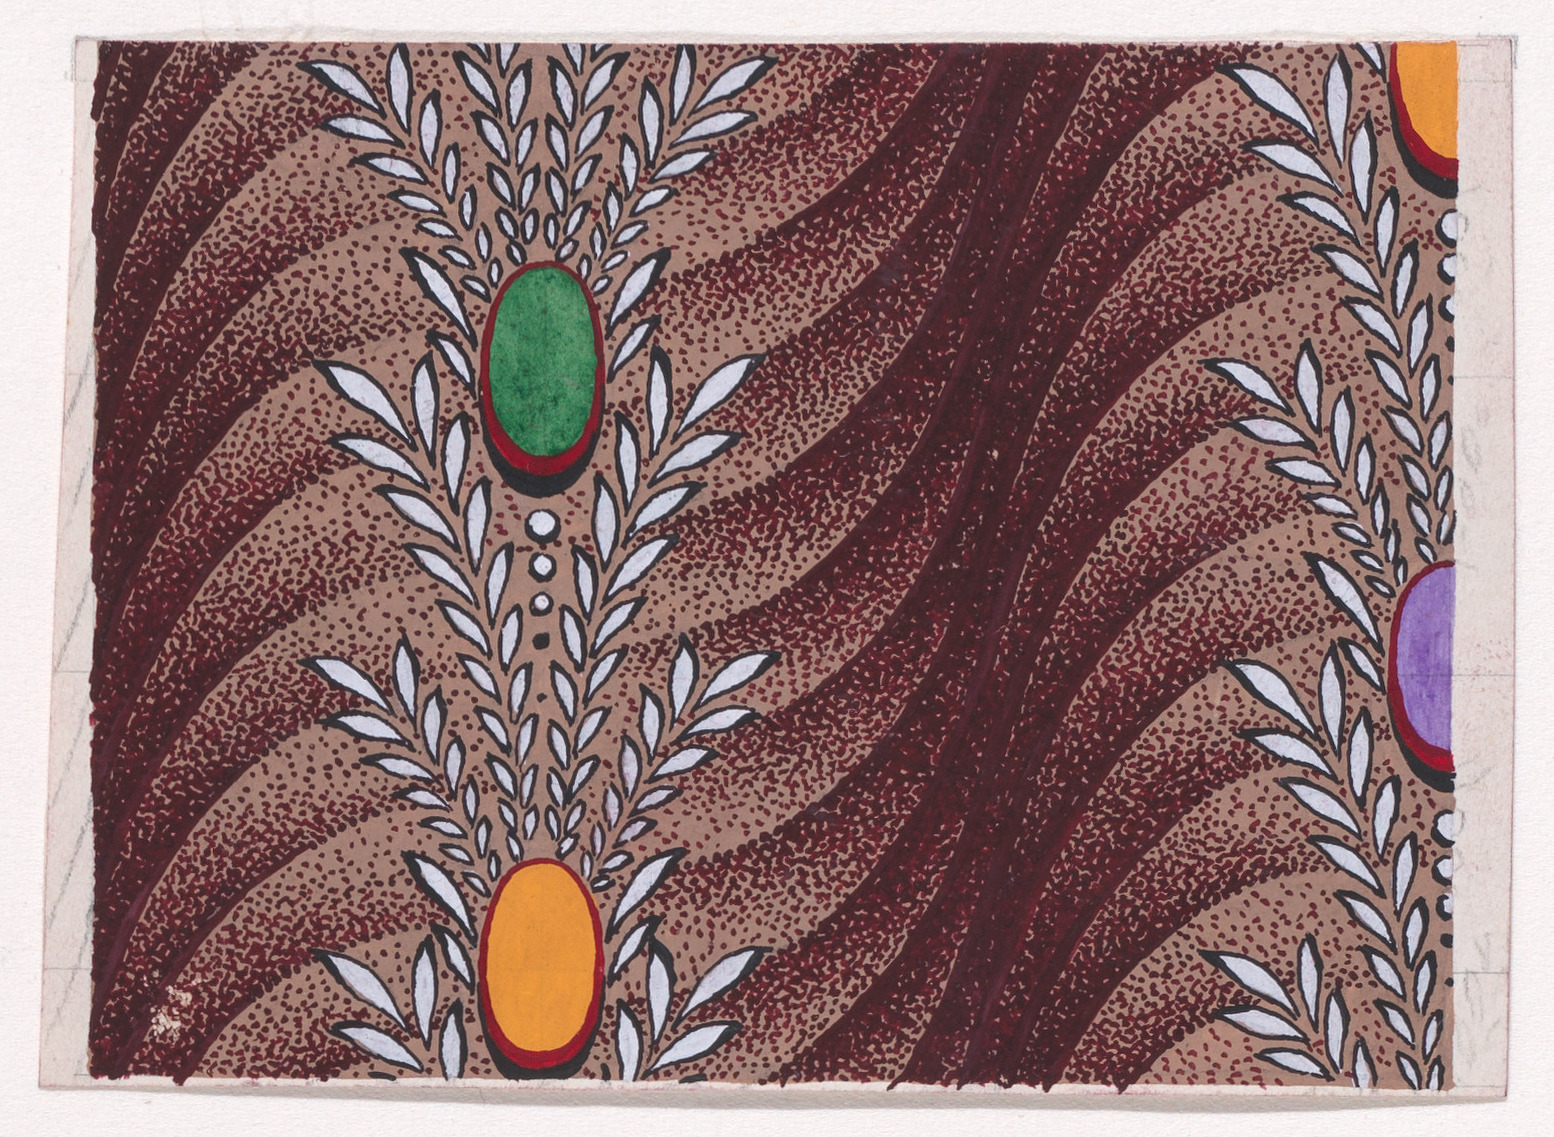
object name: drawing ornament architecture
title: Textile Design with Vertical Garlands of Stylized Leaves, Pearls and Ovals over a Background of Overlapping Scales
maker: anonymous, alsatian, 19th century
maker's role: artist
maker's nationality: alsatian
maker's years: 1800-1900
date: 1840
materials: gouache